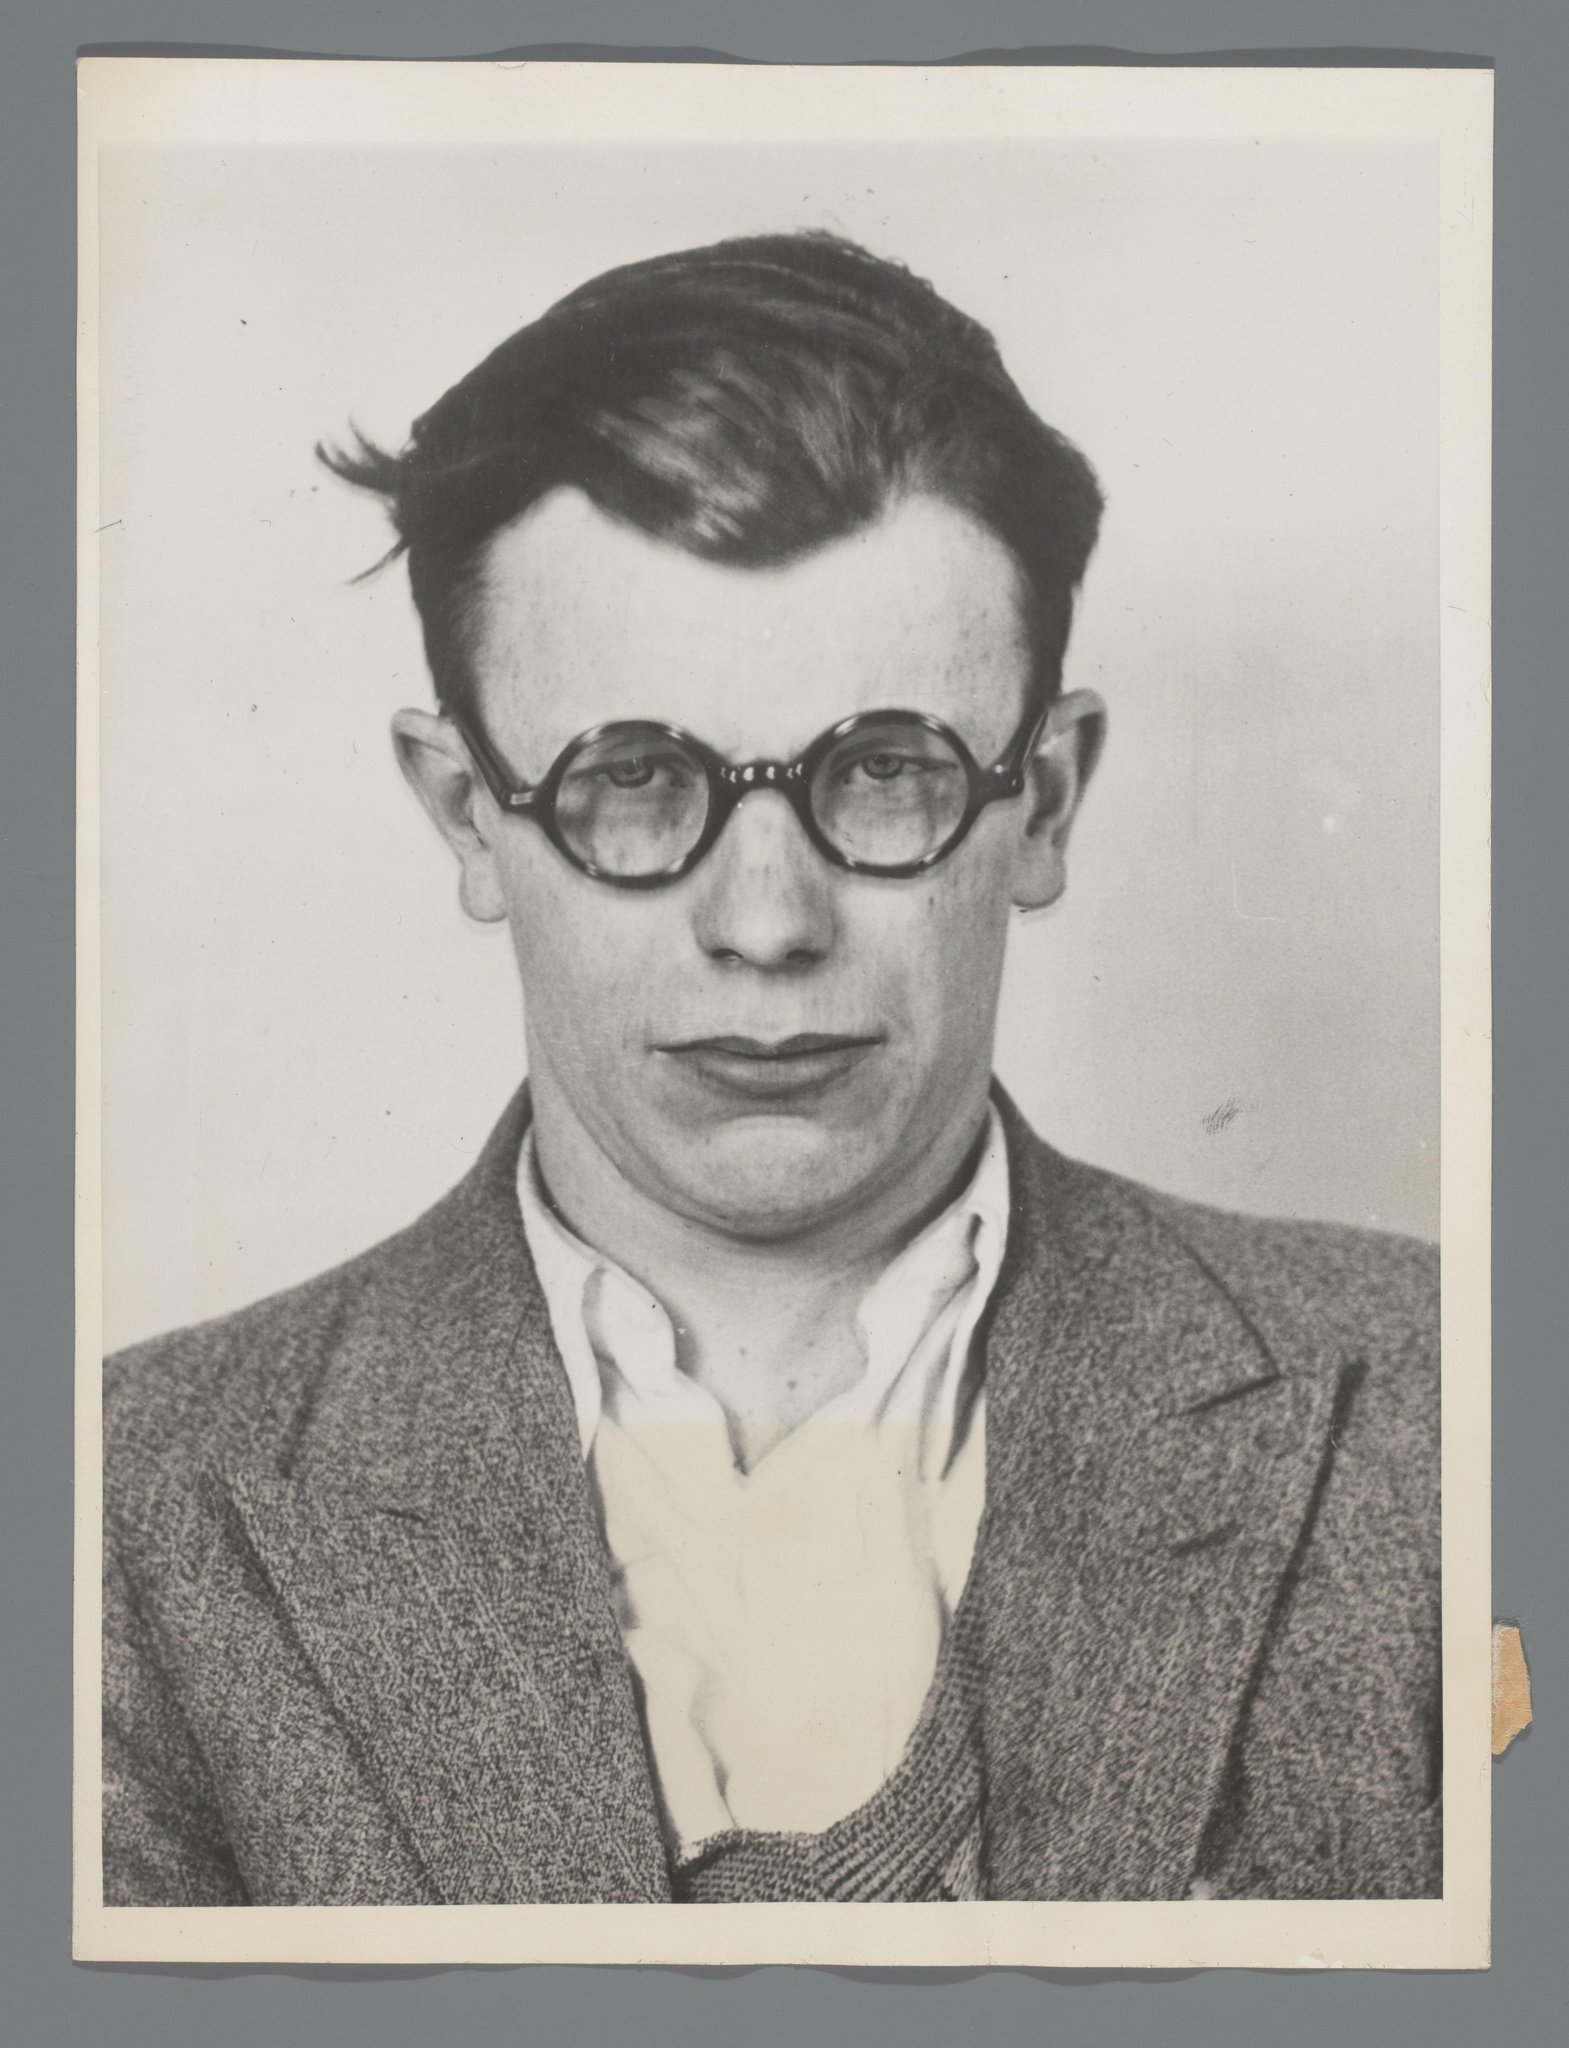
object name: photograph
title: Portret van Robert Le Clair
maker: Anonymous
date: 1931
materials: paper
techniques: gelatin silver print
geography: united states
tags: adult man, historical persons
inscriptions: number: ‘3404’, inscription: ‘573480 - - watch your credit..international newsreel photo/ slug..(Robert Le Clair)/ Rode in death car/ New York...Robert Le Clair who told police that he rode in the/ automobile in which Virginia Brannen, taxe-dancer was/ shot to death./ E-april 29, 31’, inscription: ‘MAY 2 1931/ CENTRAL PRESS ASSOCIATION/ REFERENCE DEPT.’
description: Robert Le Clair was aanwezig bij de moord op 'taxi-dancer' Virginia Brannen.